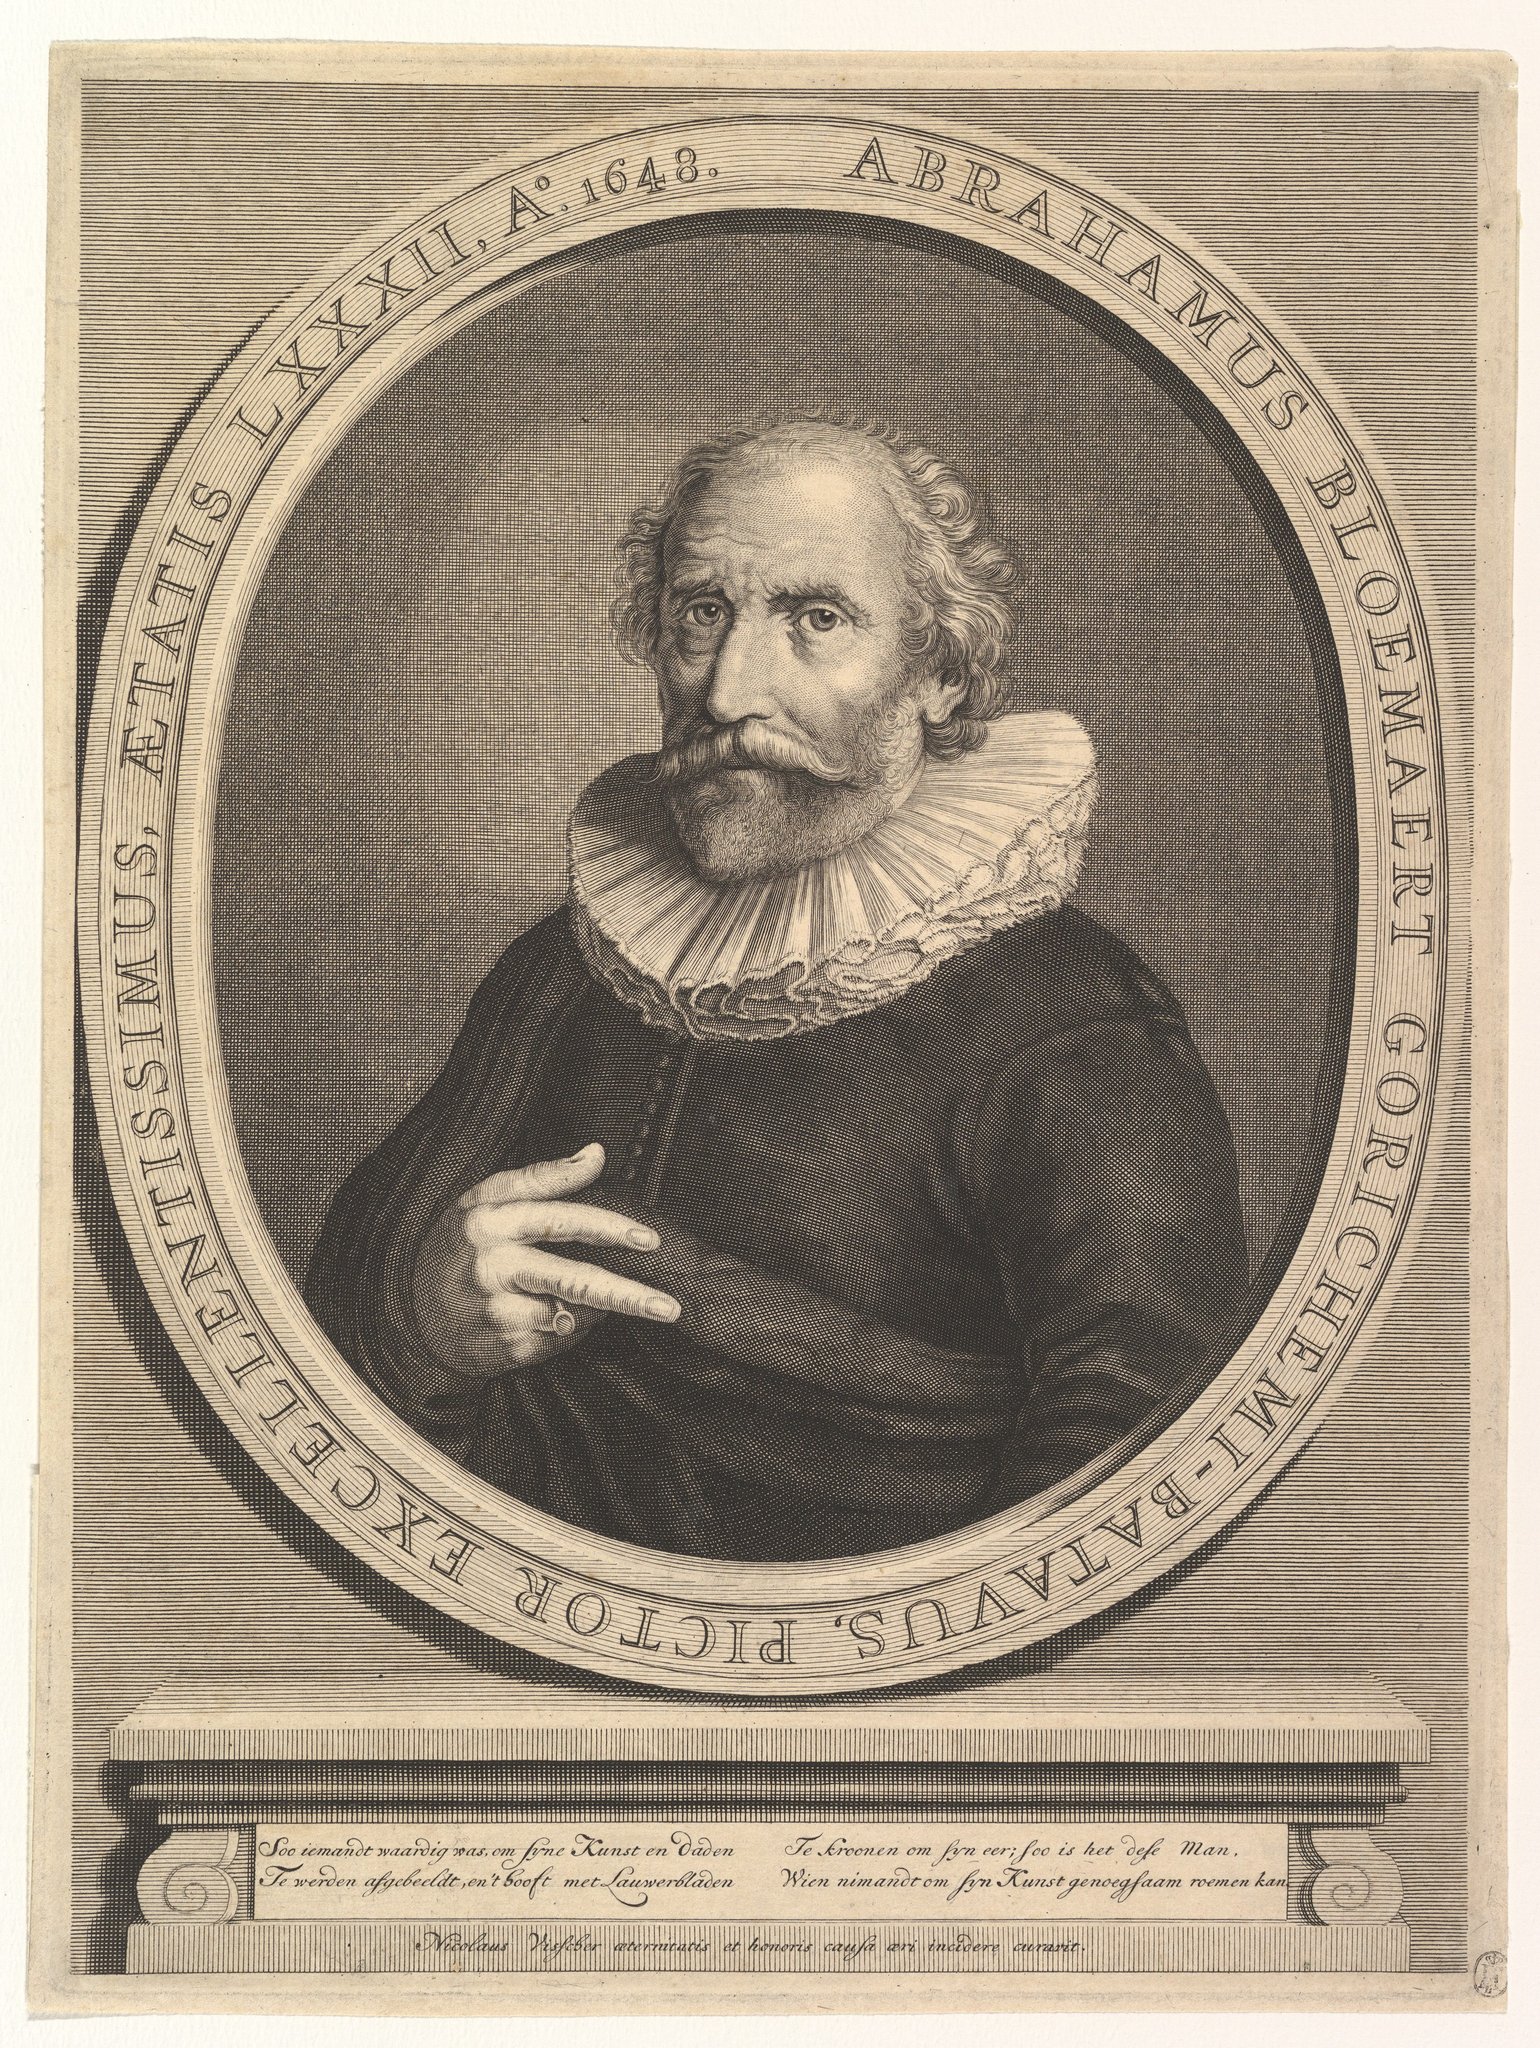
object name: print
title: Portrait of Abraham Bloemaert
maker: nicolas visscher i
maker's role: artist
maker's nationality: dutch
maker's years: 1618-1679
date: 1601-1700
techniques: engraving, etching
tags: men,portraits